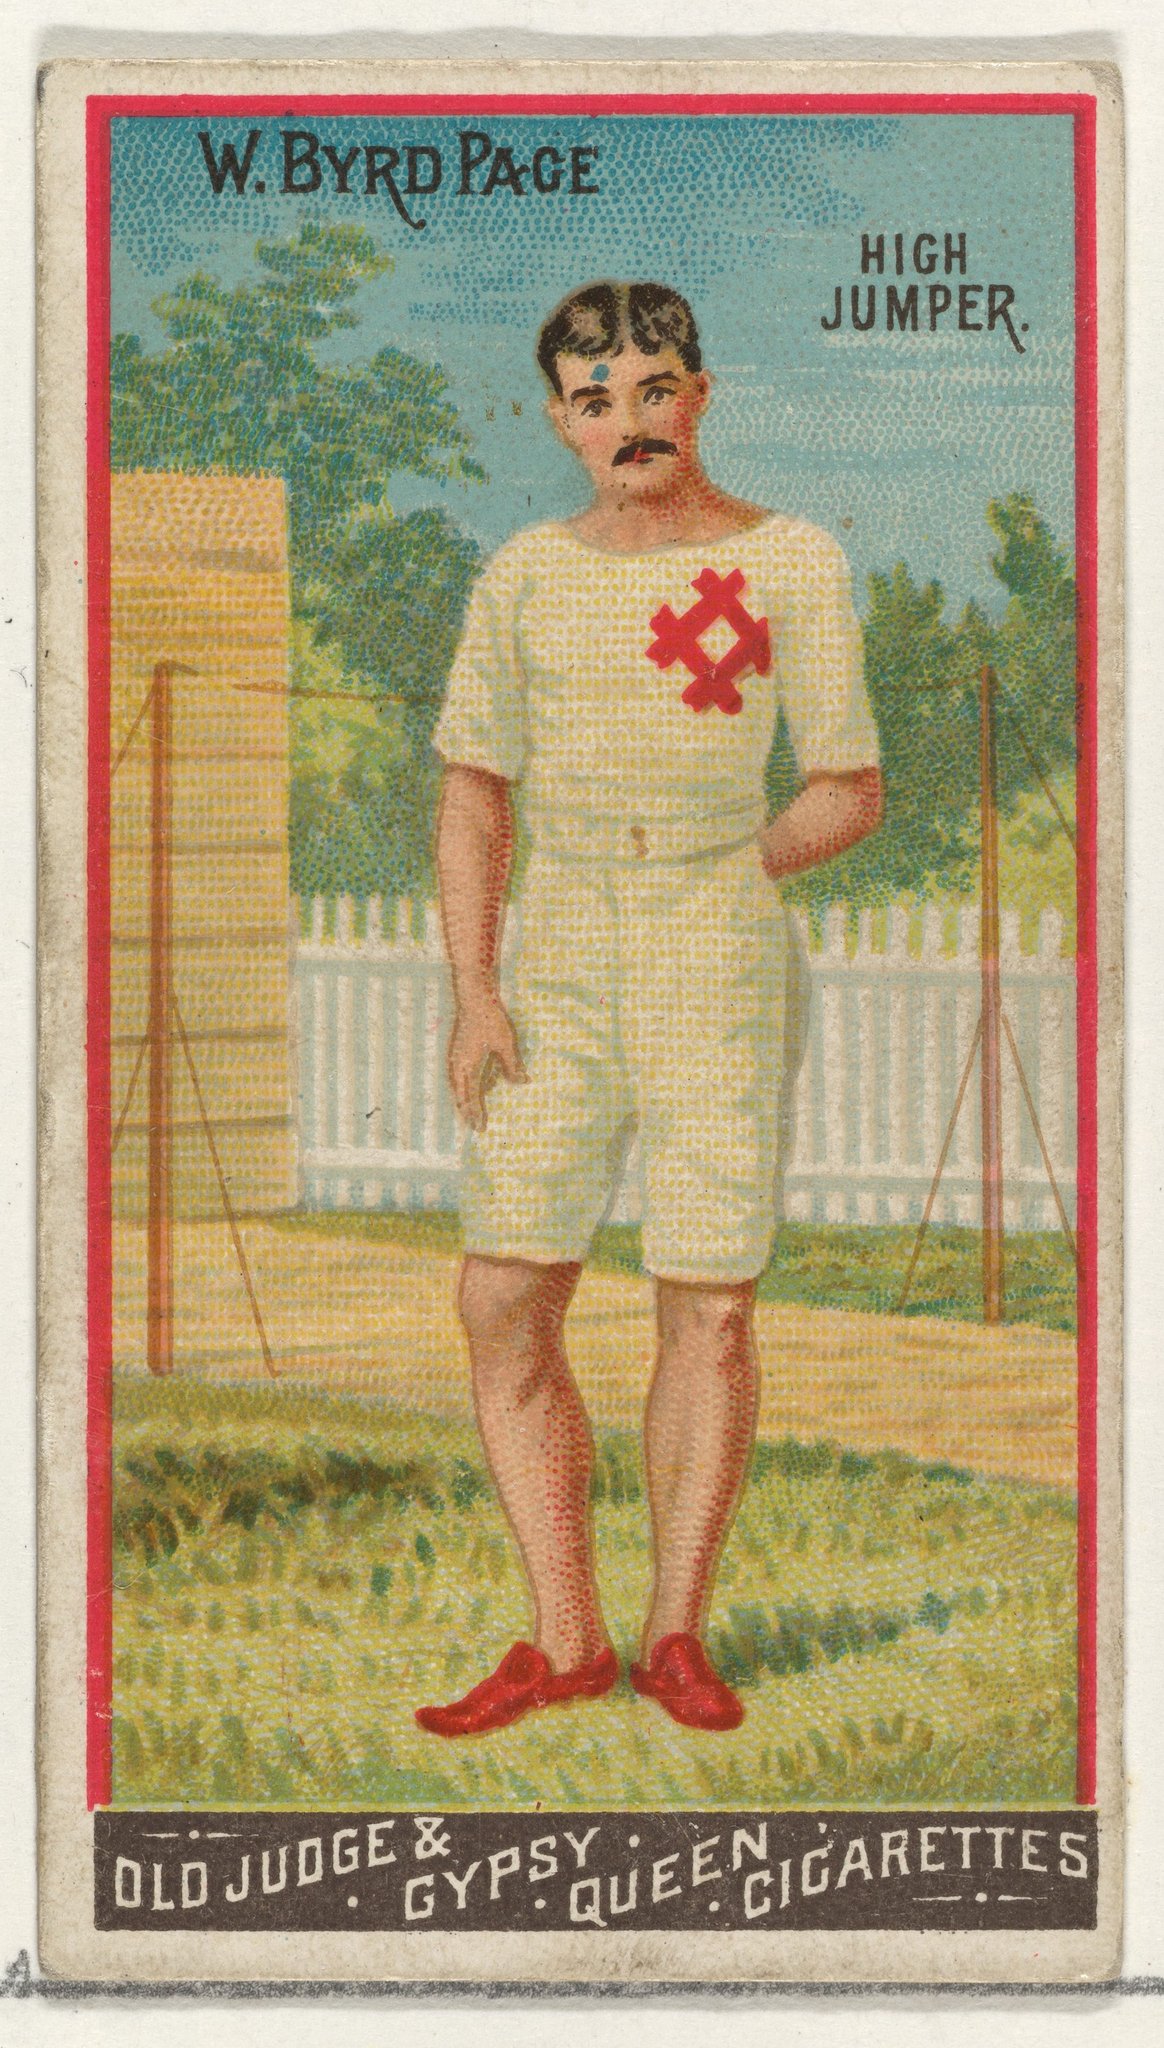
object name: print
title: William Byrd Page, High Jumper, from the Goodwin Champion series for Old Judge and Gypsy Queen Cigarettes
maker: goodwin & company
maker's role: publisher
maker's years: 1850-1950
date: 1888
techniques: color lithograph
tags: men,portraits,athletes